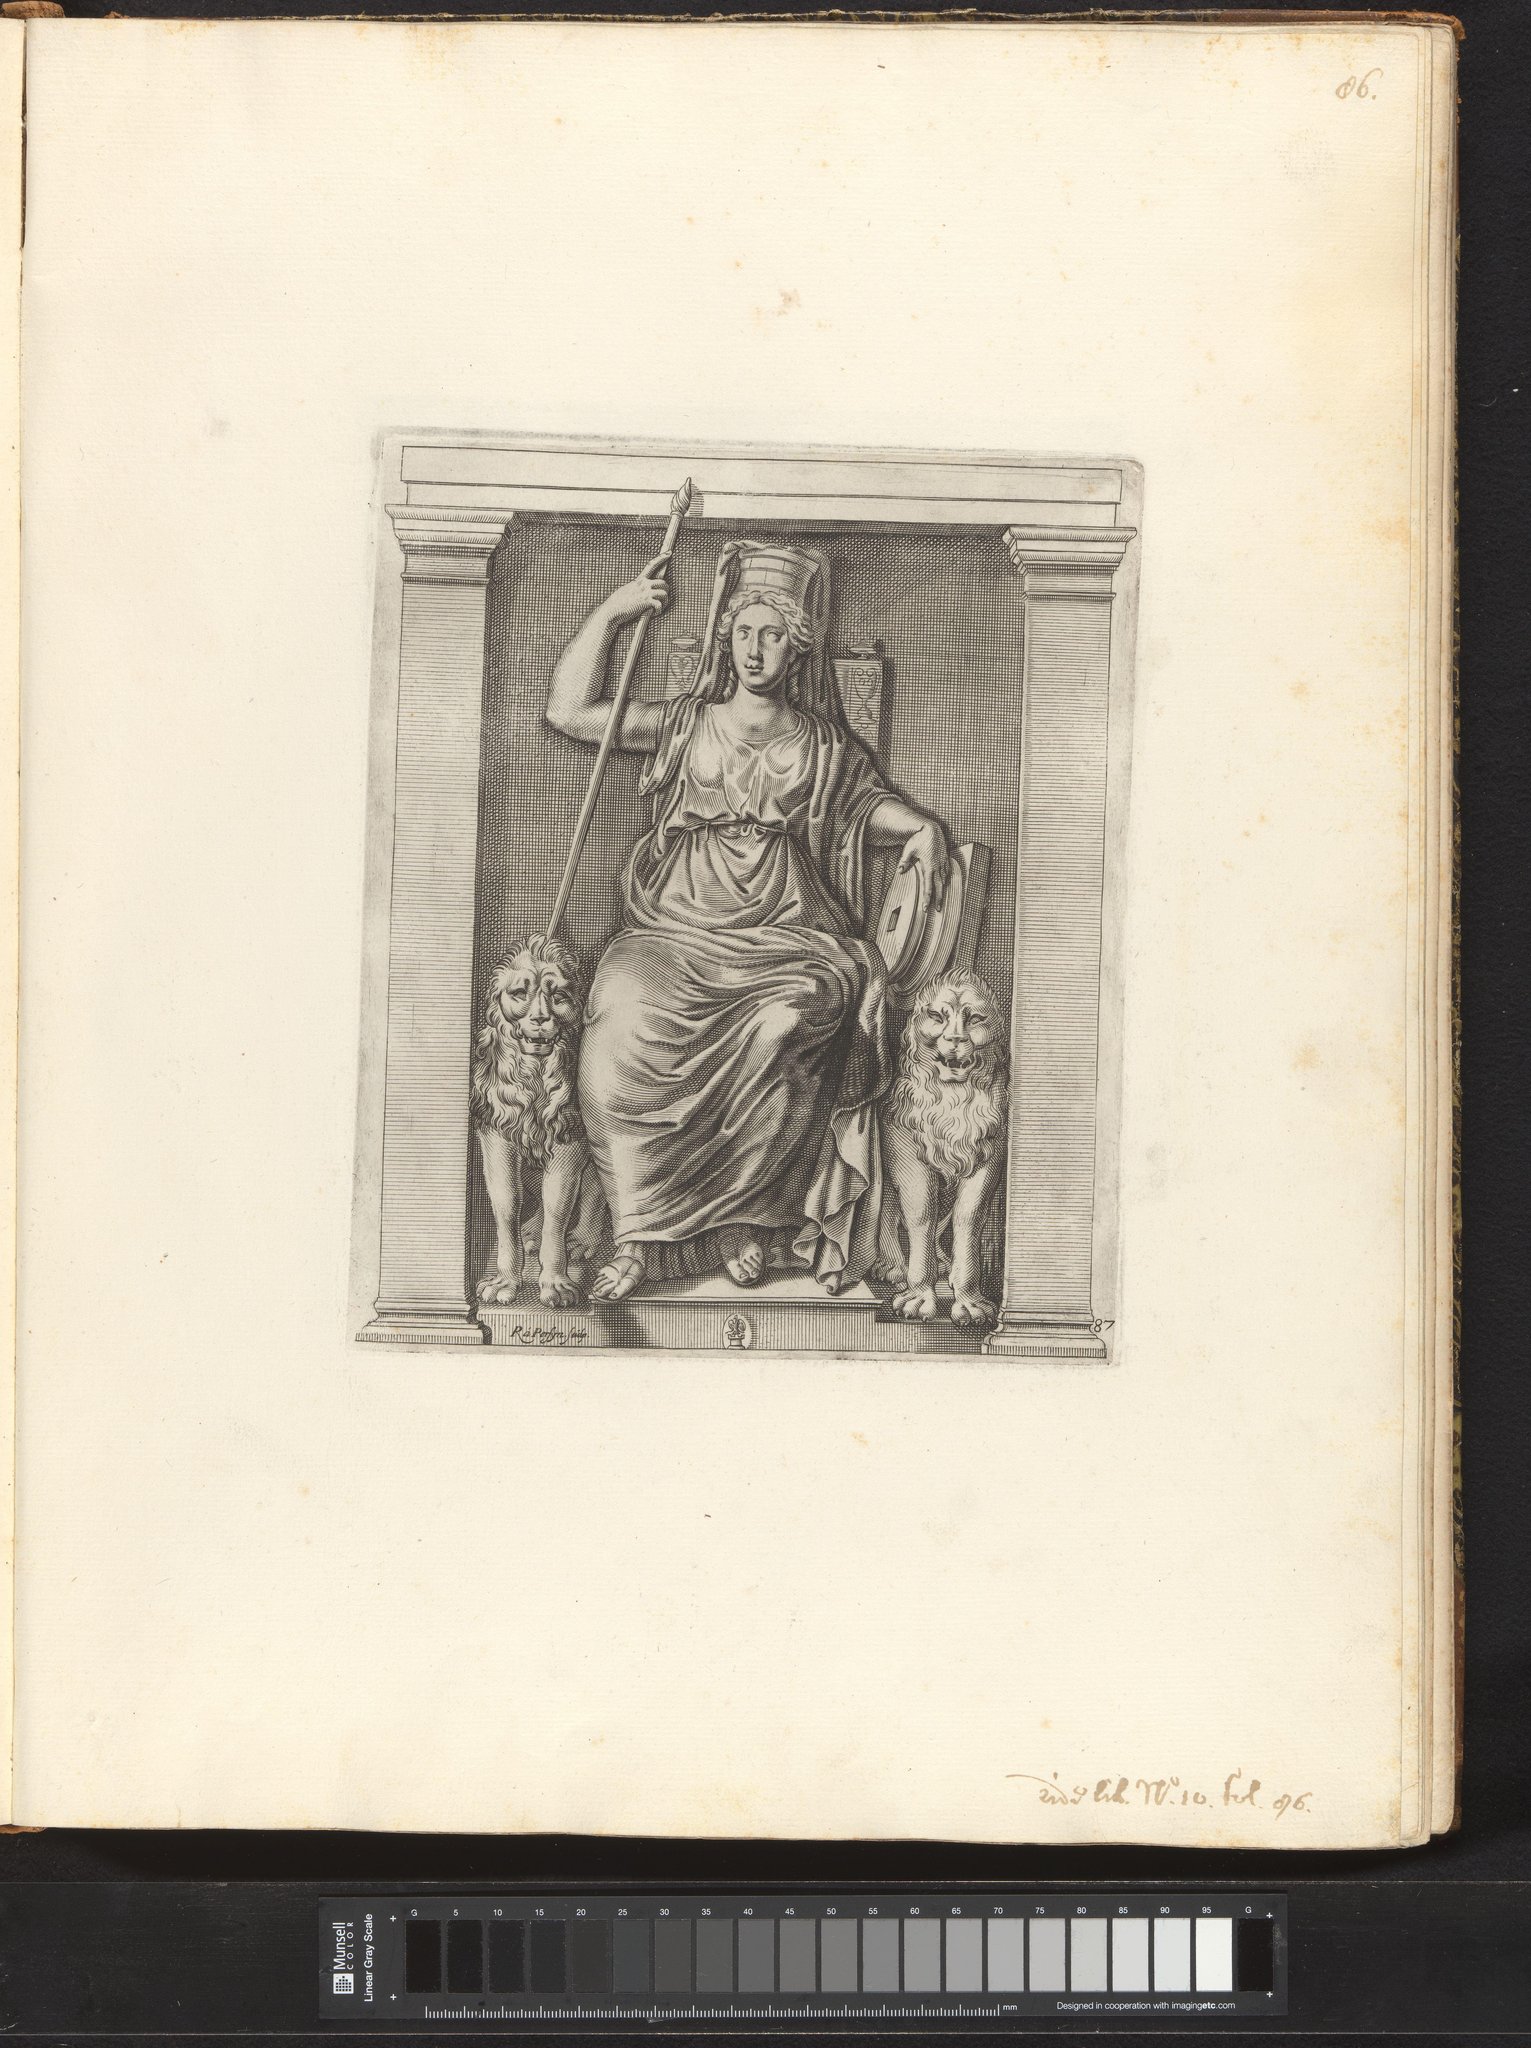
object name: print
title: Galleria Giustiniana del Marchese Vincenzo Giustiniani II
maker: reinier van persijn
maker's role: draughtsman, painter, print maker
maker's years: 1614-1668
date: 1636-1647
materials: paper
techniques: engraving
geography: rome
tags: (story of) minerva (pallas, athena), piece of sculpture, reproduction of a piece of sculpture, the muses acting together (as group)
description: Bas-reliëf met Minerva en zes muzen. Voor Minerva een adelaar, wellicht het attribuut van de god Jupiter. Midden onder het wapenschild van Vincenzo Giustiniani. Prent maakt deel uit van een album met een serie prenten naar de sculpturen in de verzameling in de Galleria Giustiniani te Rome.